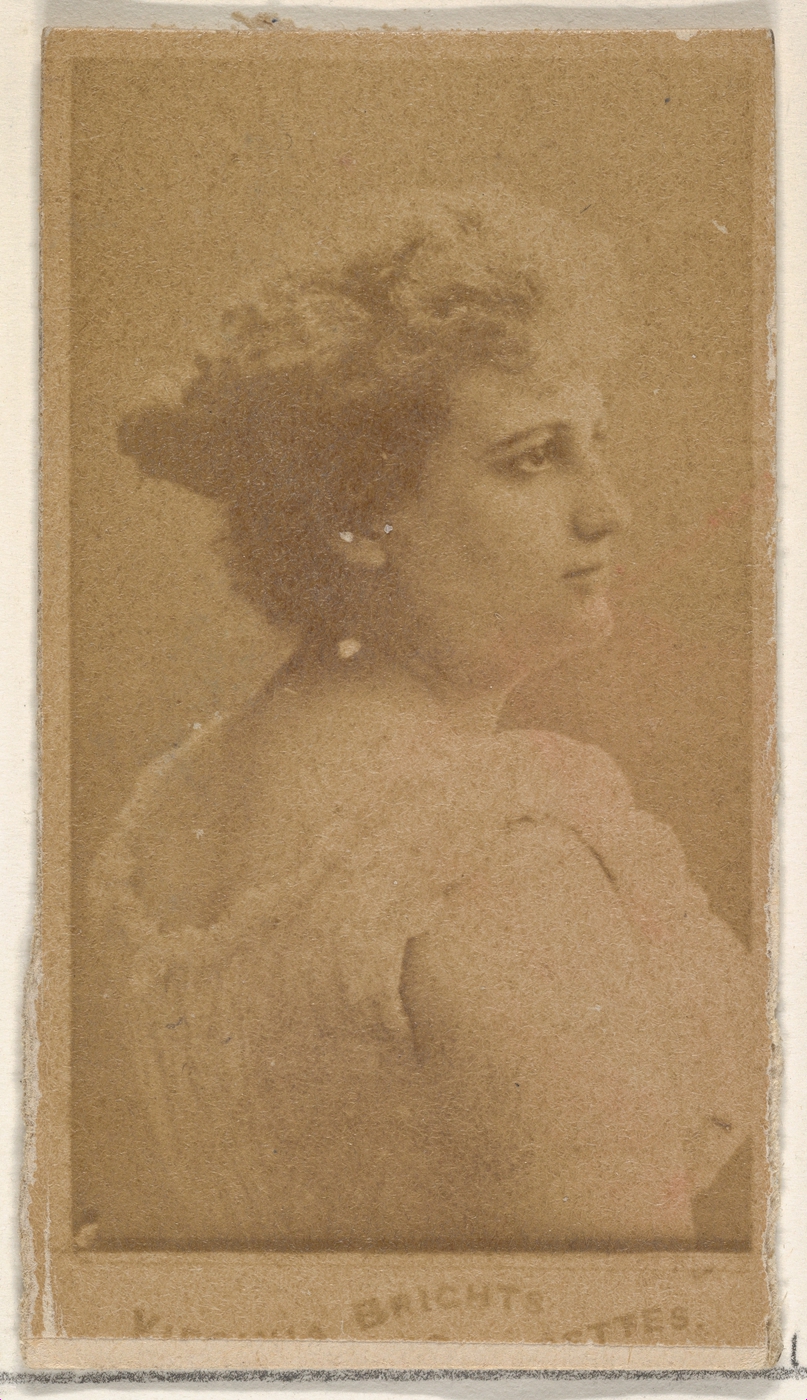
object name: photograph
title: From the Actors and Actresses series (N45, Type 4) for Virginia Brights Cigarettes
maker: allen & ginter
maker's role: publisher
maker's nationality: american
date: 1888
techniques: albumen silver print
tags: women,actresses